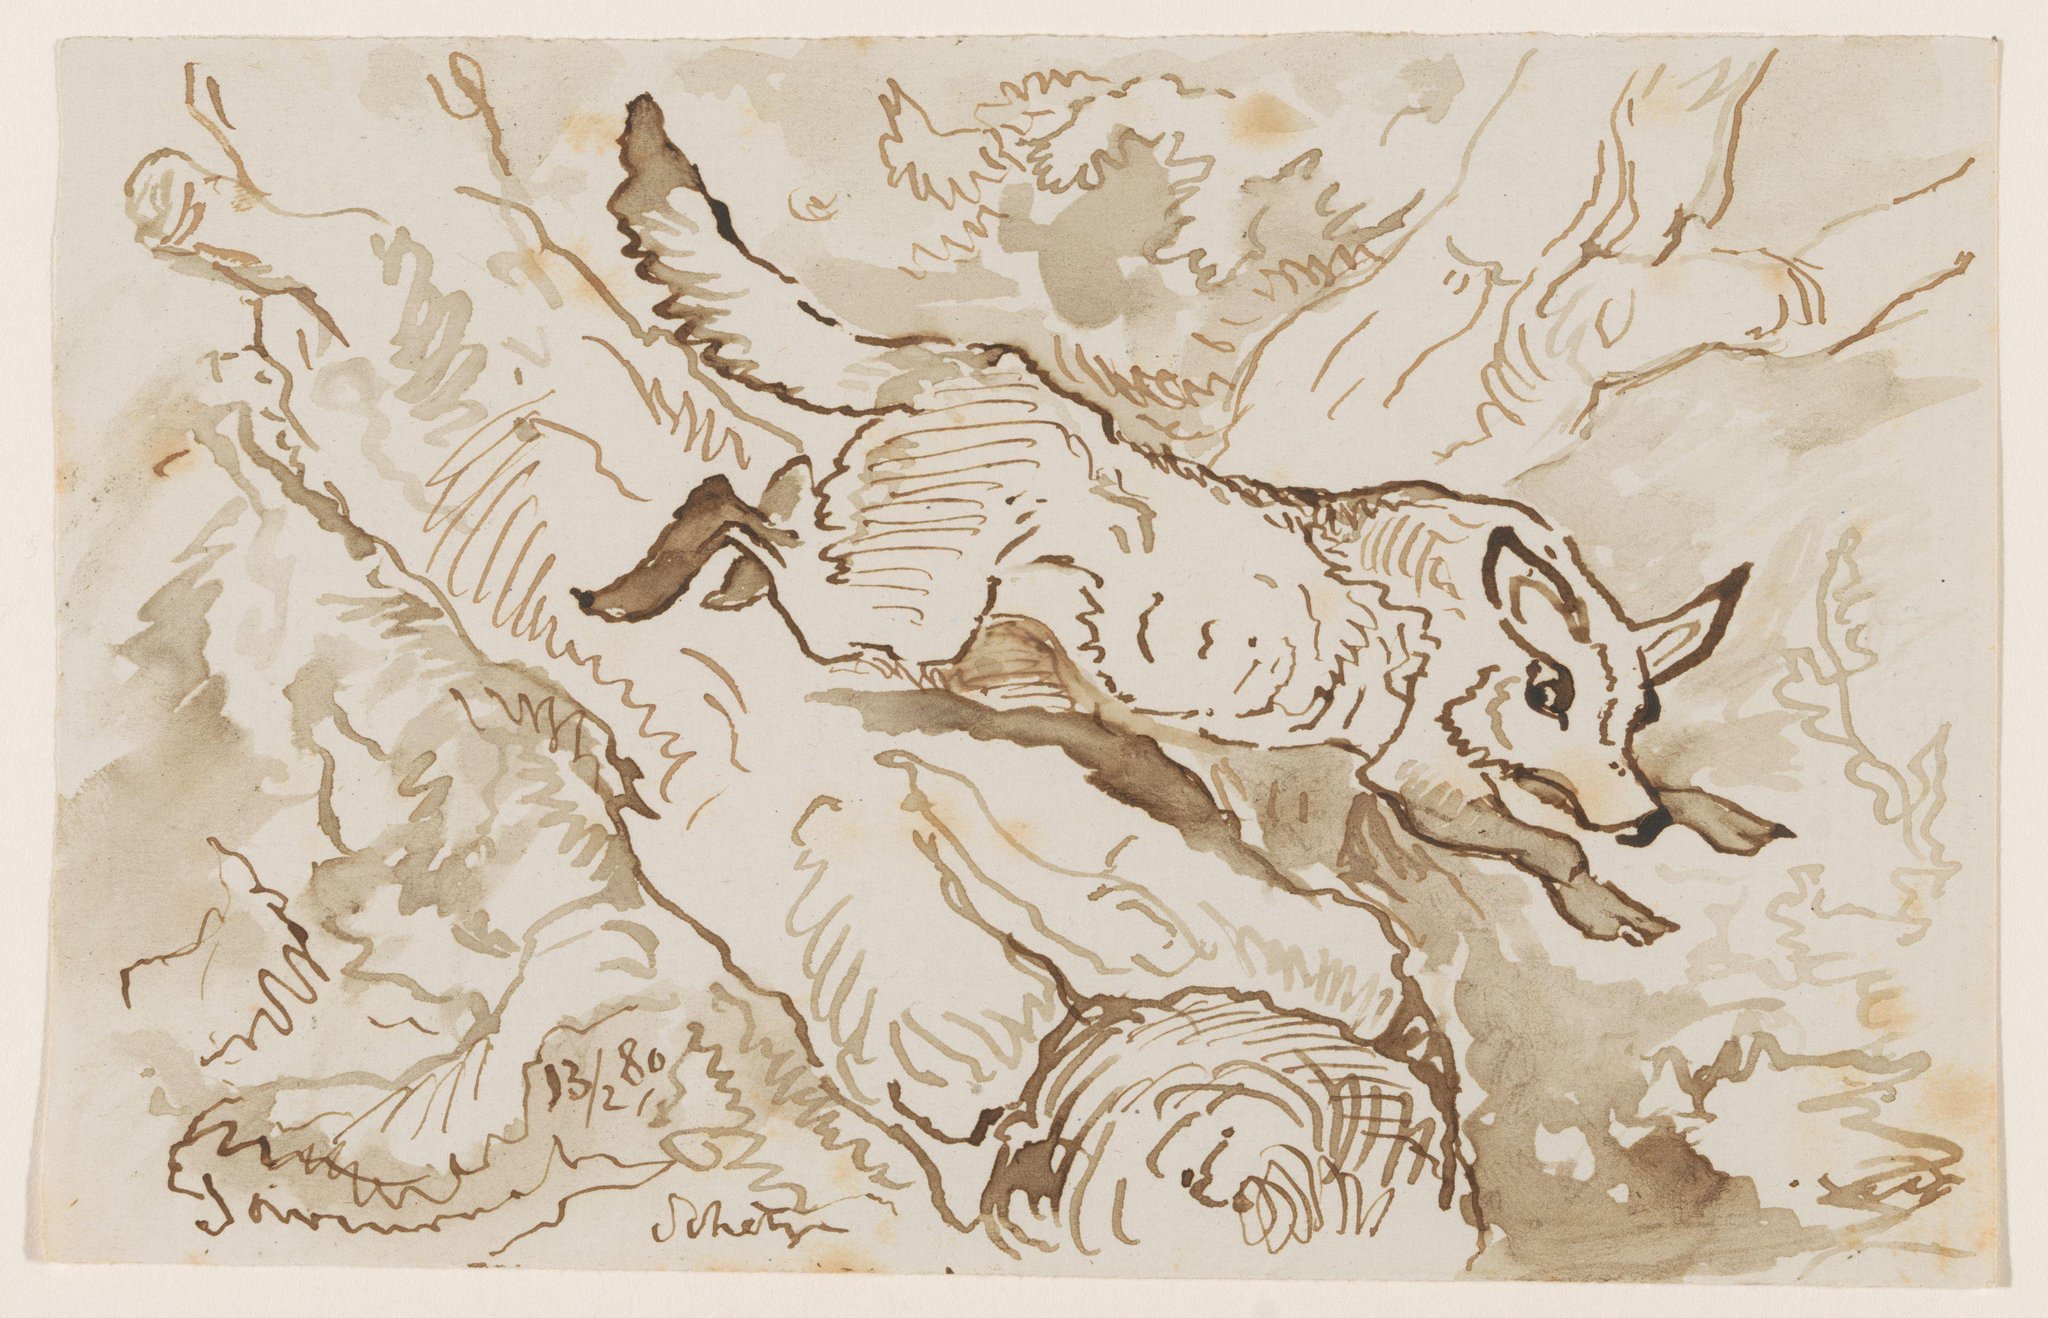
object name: drawing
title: Wolf of vos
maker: johannes tavenraat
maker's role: draughtsman, painter, print maker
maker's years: 1809-1881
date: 1880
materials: ink, paper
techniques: brush, pen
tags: fox hunting, beasts of prey, predatory animals: fox, beasts of prey, predatory animals: wolf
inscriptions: collector's mark: Lugt 2228, signature, date and inscription: ‘Tavenraat 13/2 80. Schets’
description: Wolf of vos, in het bos, springend over een boomstam.